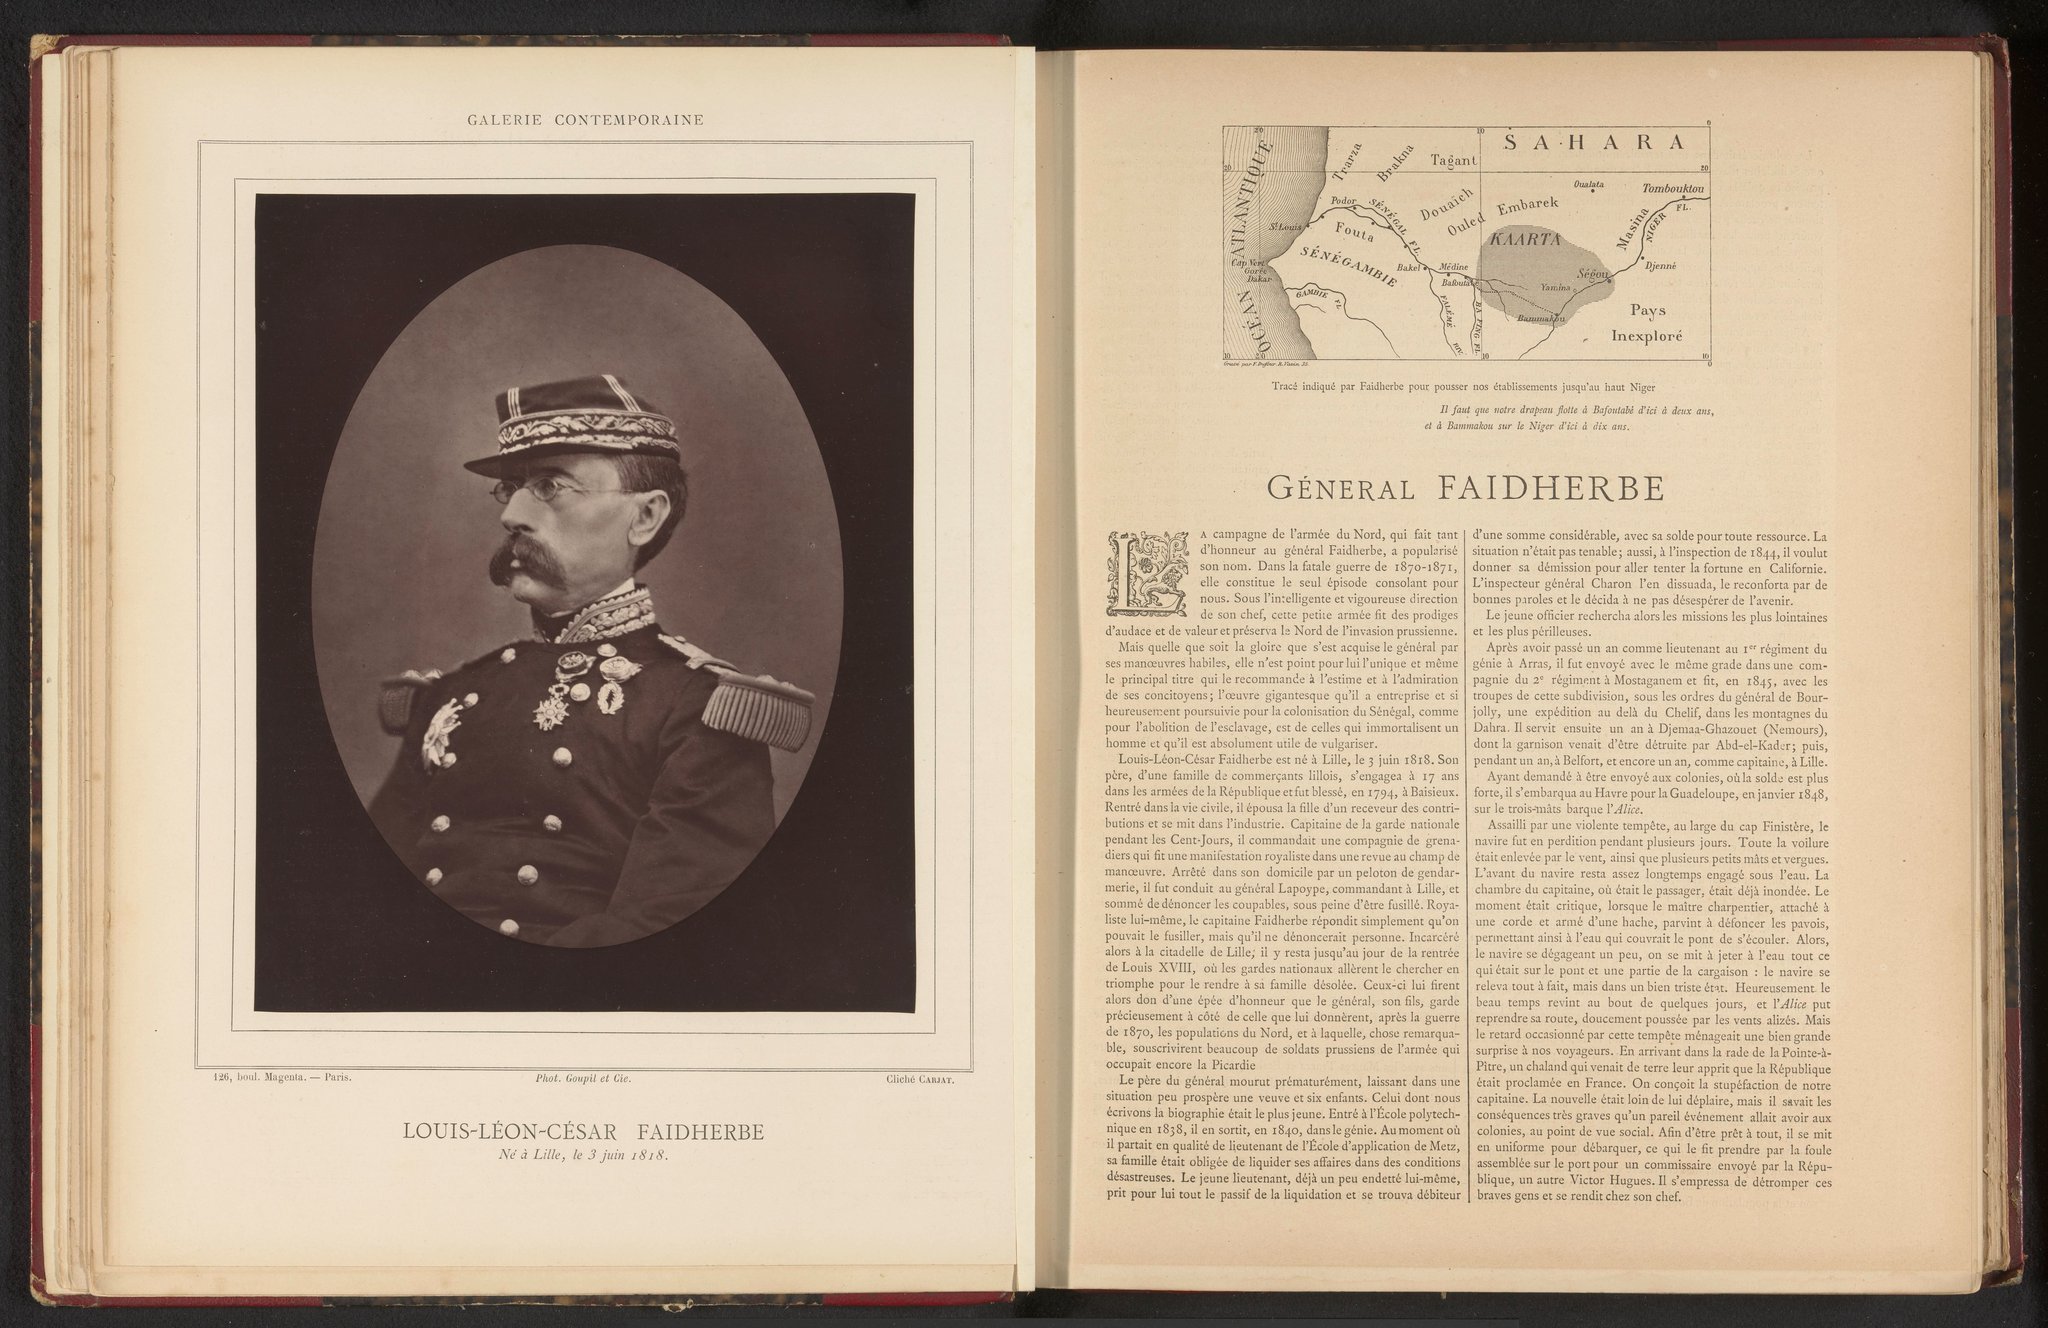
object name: photomechanical print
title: Portret van Louis Léon César Faidherbe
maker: étienne carjat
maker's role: draughtsman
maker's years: 1828-1906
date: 1876-1879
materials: paper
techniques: woodburytype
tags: commander-in-chief, general, marshal, (military) uniforms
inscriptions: inscription: ‘126, boul. Magenta.-Paris.’